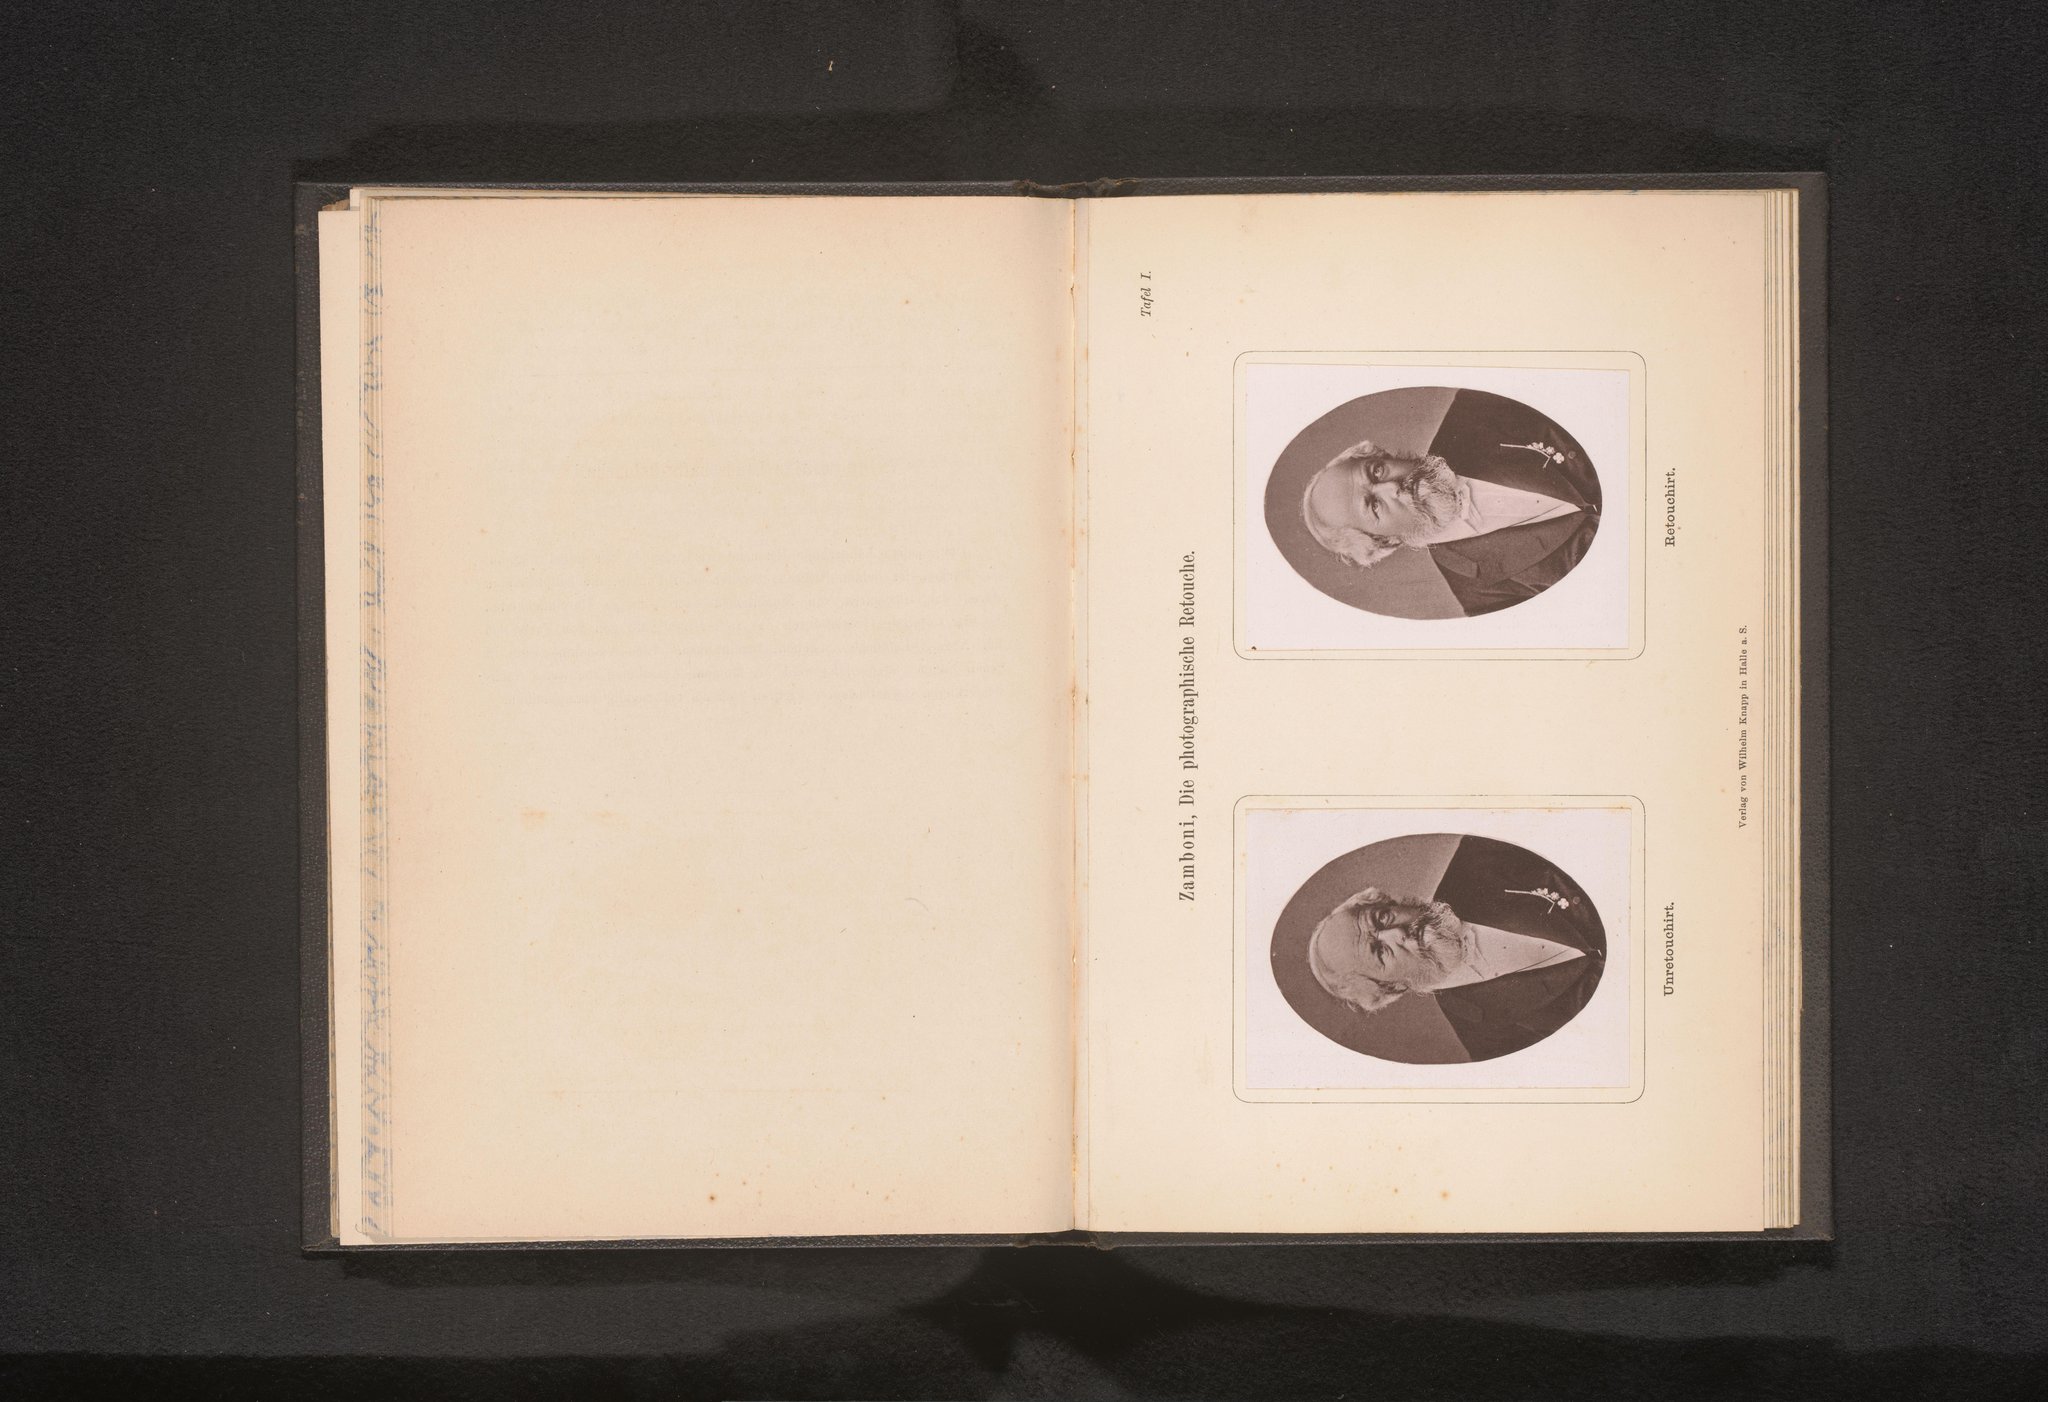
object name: page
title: Twee portretten van een onbekende man, met en zonder retouche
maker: Anonymous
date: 1878-1888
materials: paper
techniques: photograph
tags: old man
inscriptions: inscription: ‘Unretouchirt. Retouchirt.’, number: ‘Tafel I.’